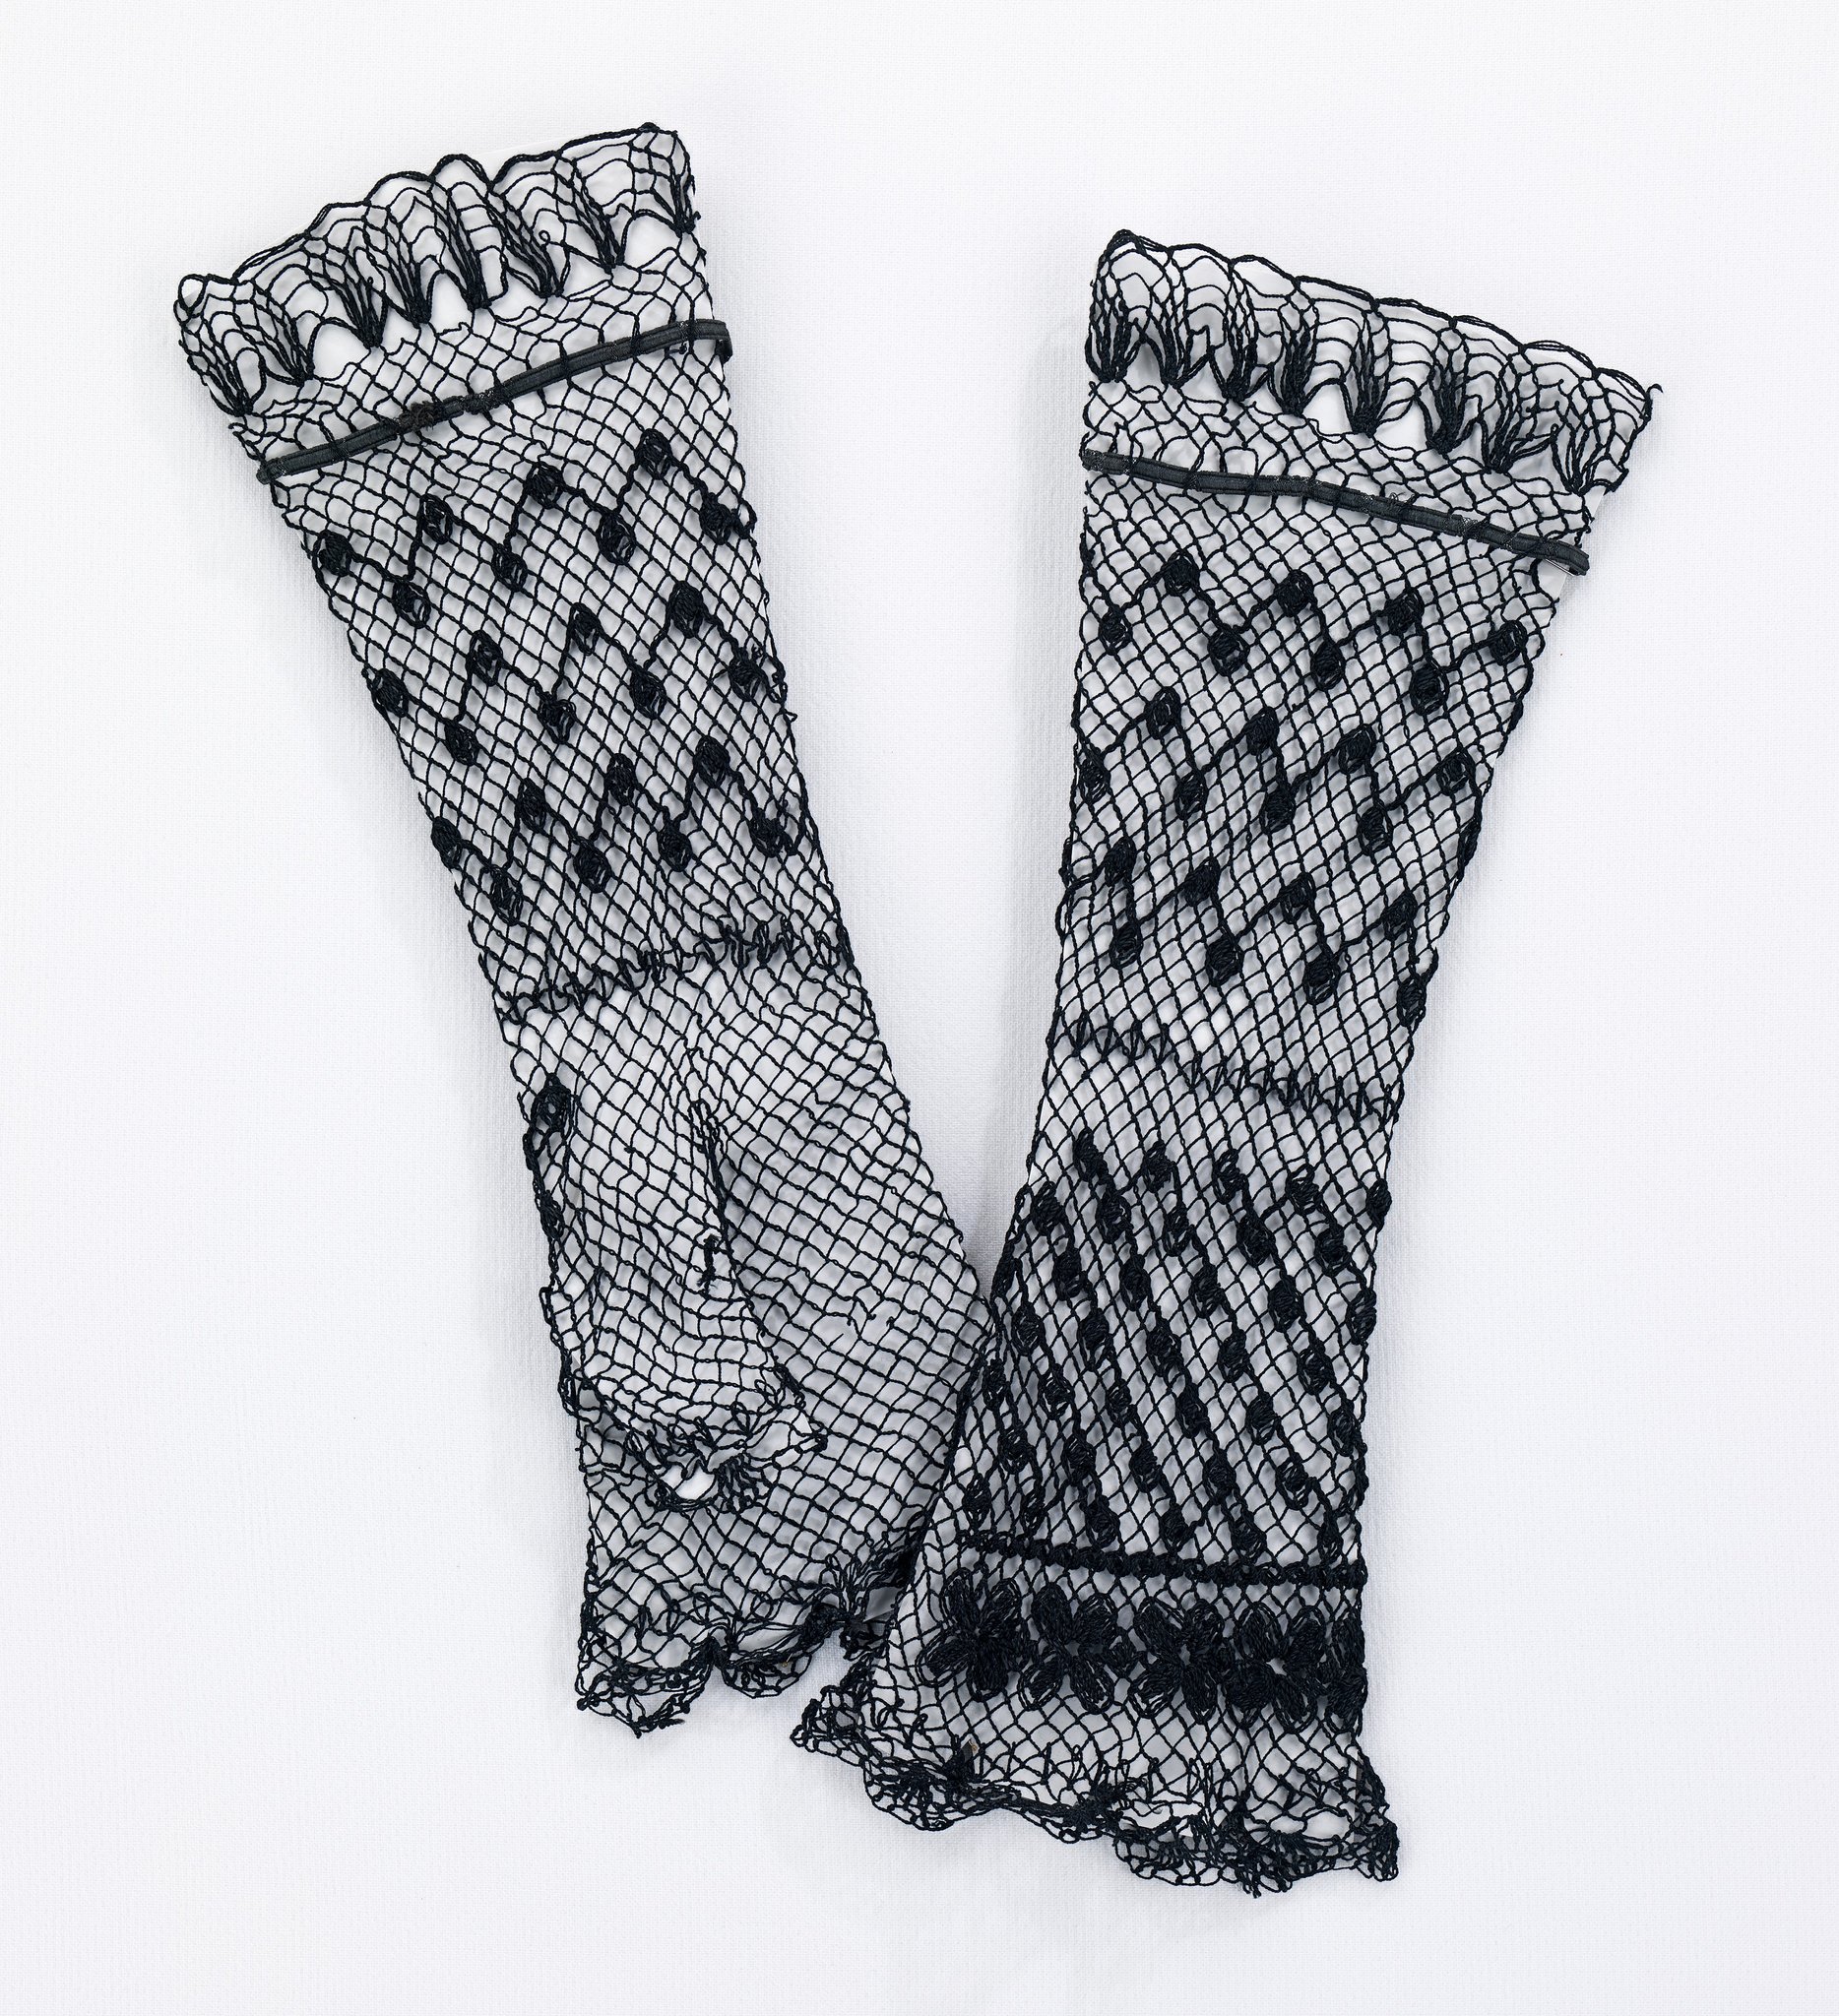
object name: mitt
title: Mitts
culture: american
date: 1870-1879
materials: cotton